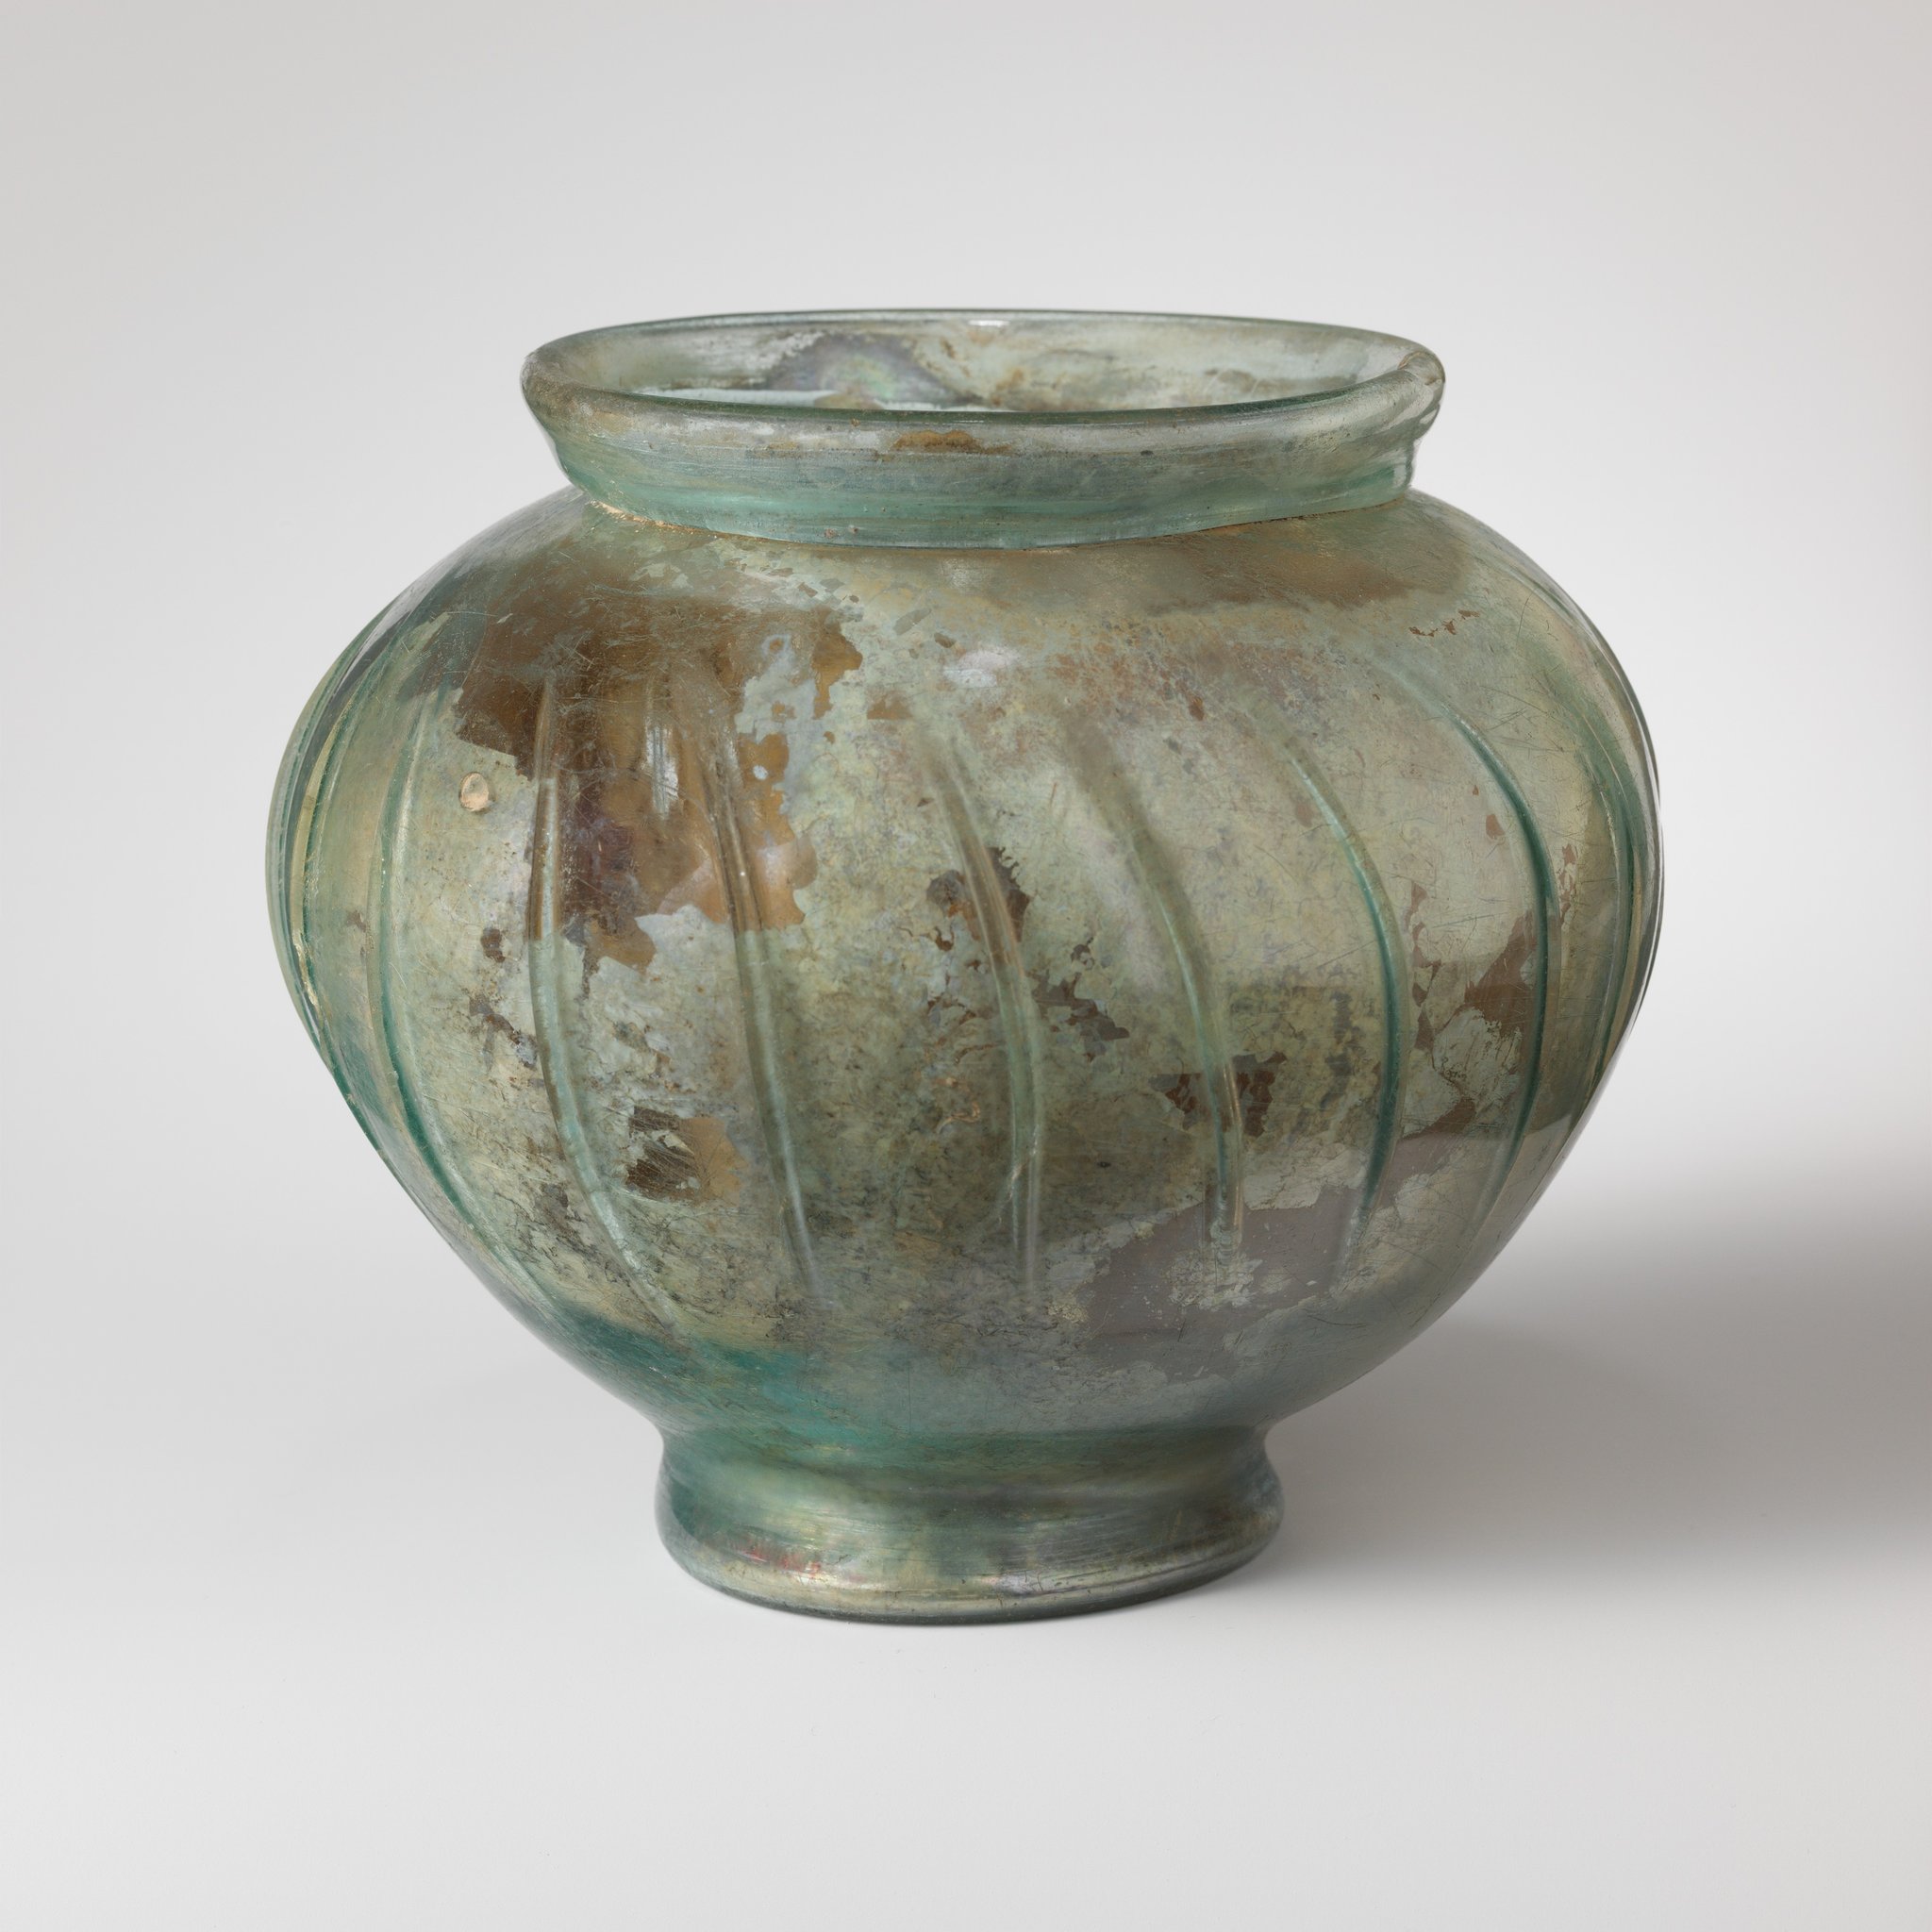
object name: jar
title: Glass jar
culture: roman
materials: glass